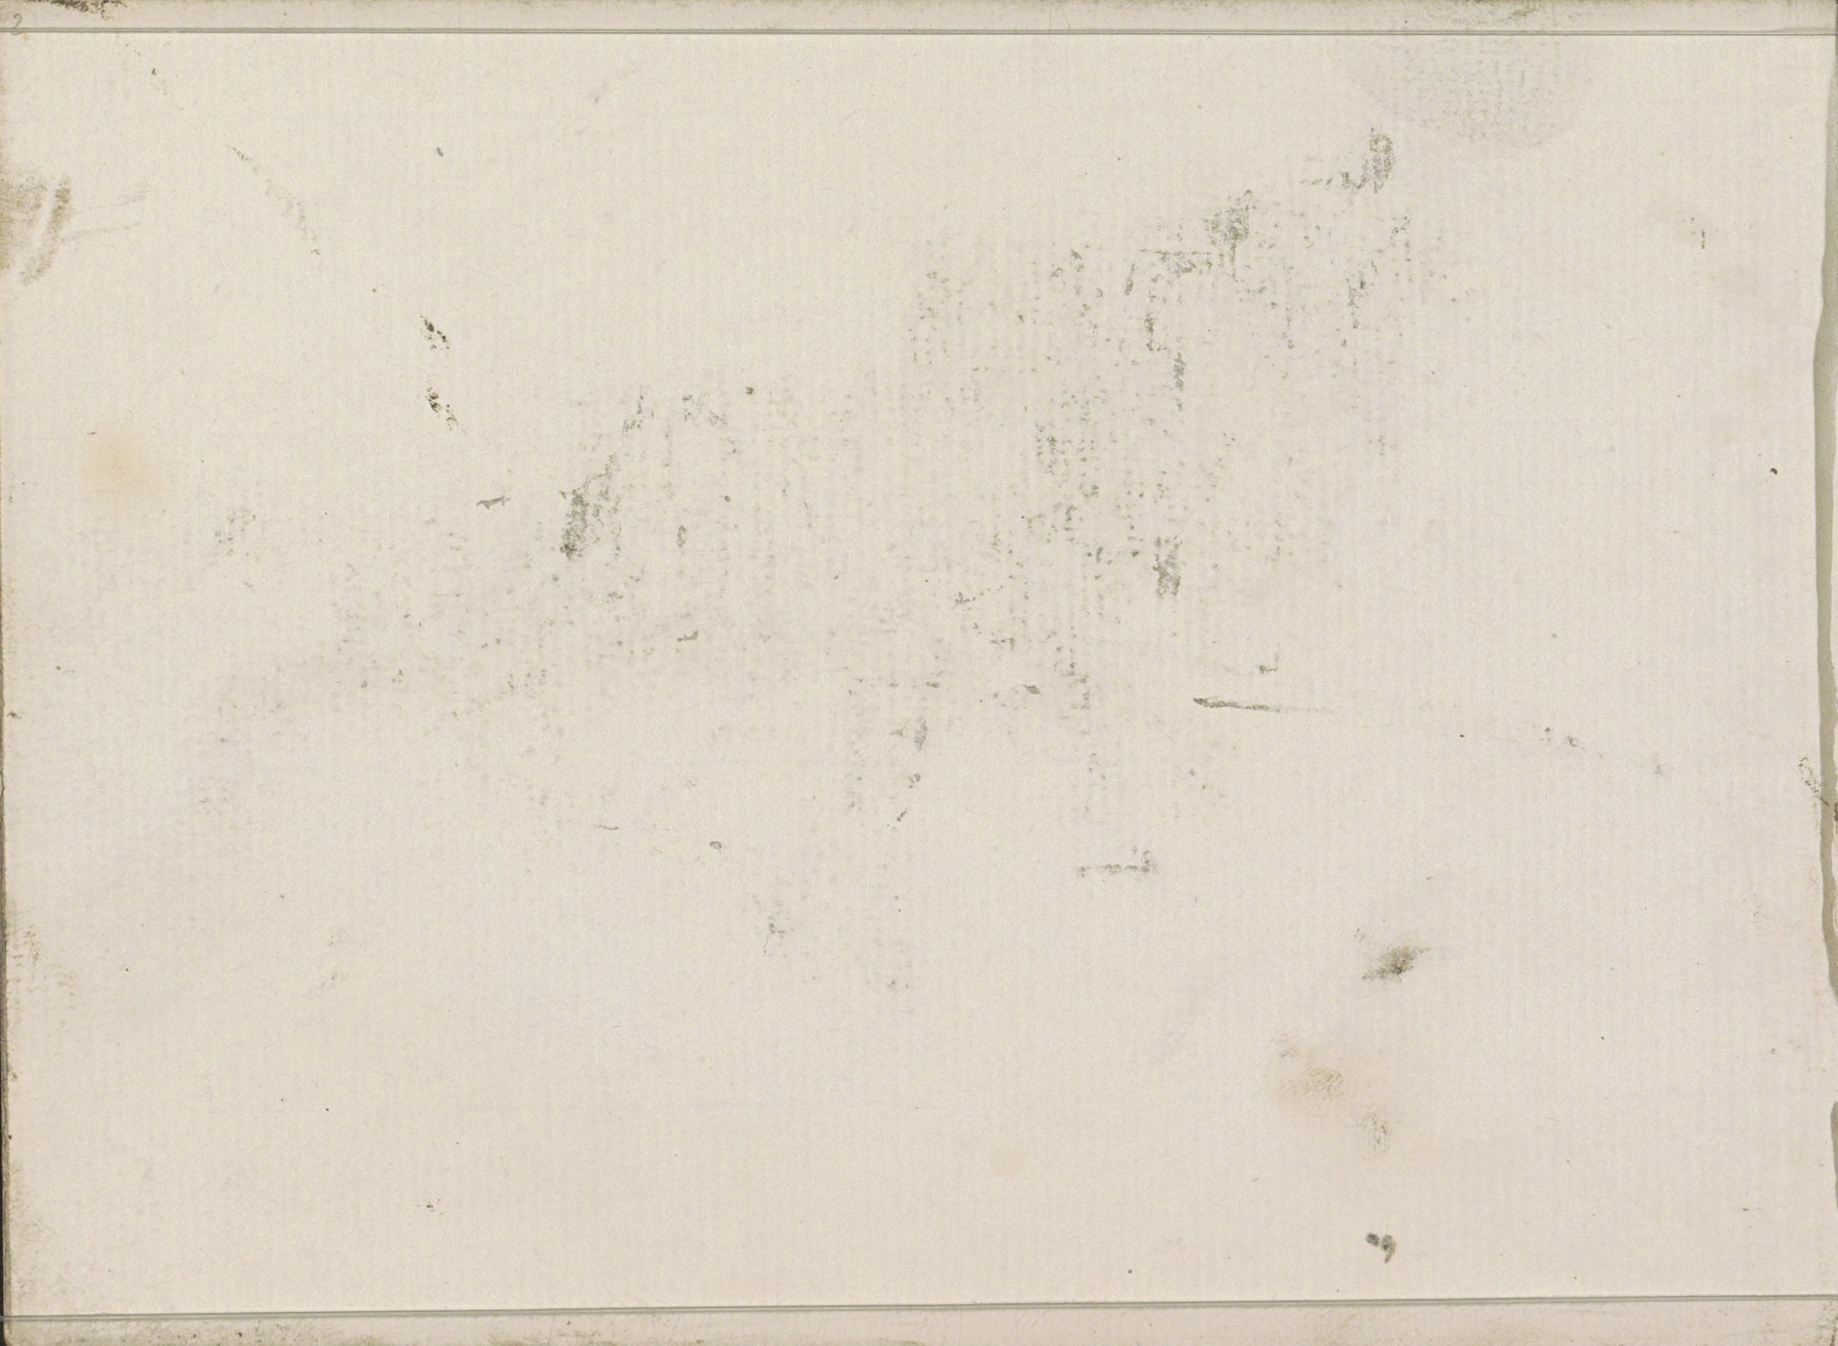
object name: sketchbook leaf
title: Abklatsch van de krijttekening op pagina 3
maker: isaac israels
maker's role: draughtsman, painter, print maker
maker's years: 1865-1934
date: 1886-1903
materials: paper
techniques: printmaking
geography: amsterdam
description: Pagina 2 uit schetsboek XLVII met 52 pagina's.